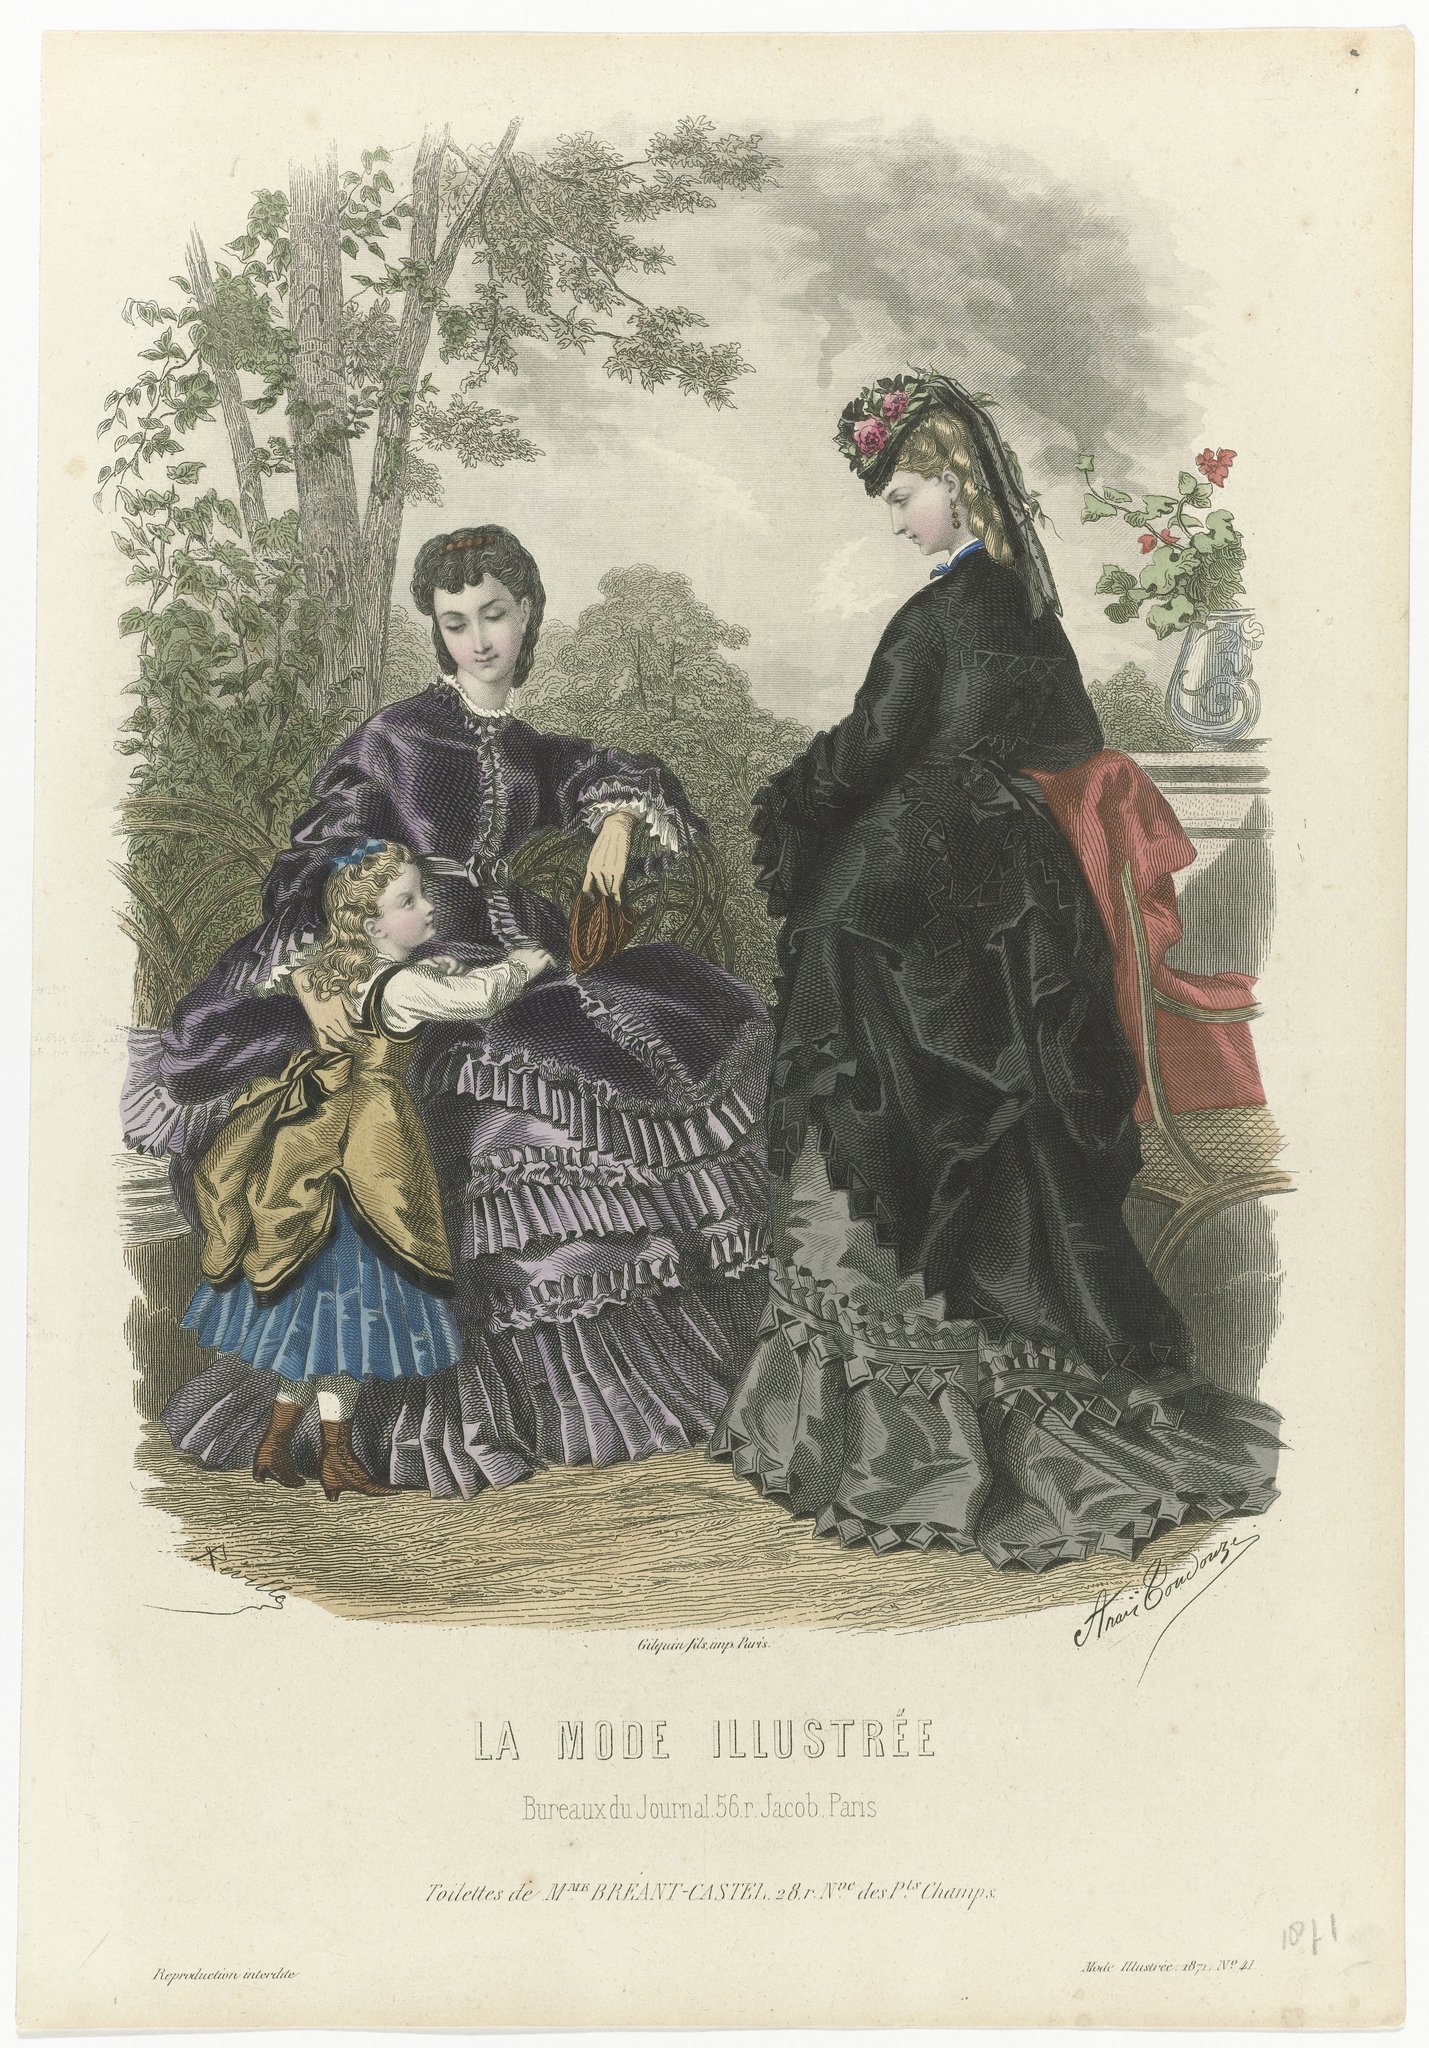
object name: fashion print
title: La Mode Illustrée, 1871, No. 41: Toilettes de Mme Breant-Castel (...)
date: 1871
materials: paper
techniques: hand coloring, engraving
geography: paris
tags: ear-rings (+ women's clothes), skirt (+ girls' clothes), diadem, tiara (+ women's clothes), boots (+ girls' clothes), coat (+ women's clothes), head-gear (+ women's clothes), fashion plates, skirt (+ women's clothes), dress, gown (+ girls' clothes)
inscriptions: address: ‘Bureaux du Journal, 56,r. Jacob. Paris’, title: ‘La Mode Illustrée’, caption: ‘Toilettes de Mme Bréant-Castel, 28. r. Nve des Pts Champs.’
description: Twee vrouwen en een meisje buiten, gekleed in japonnen van Bréant-Castel. Prent uit het modetijdschrift La Mode Illustrée (1860-1937).